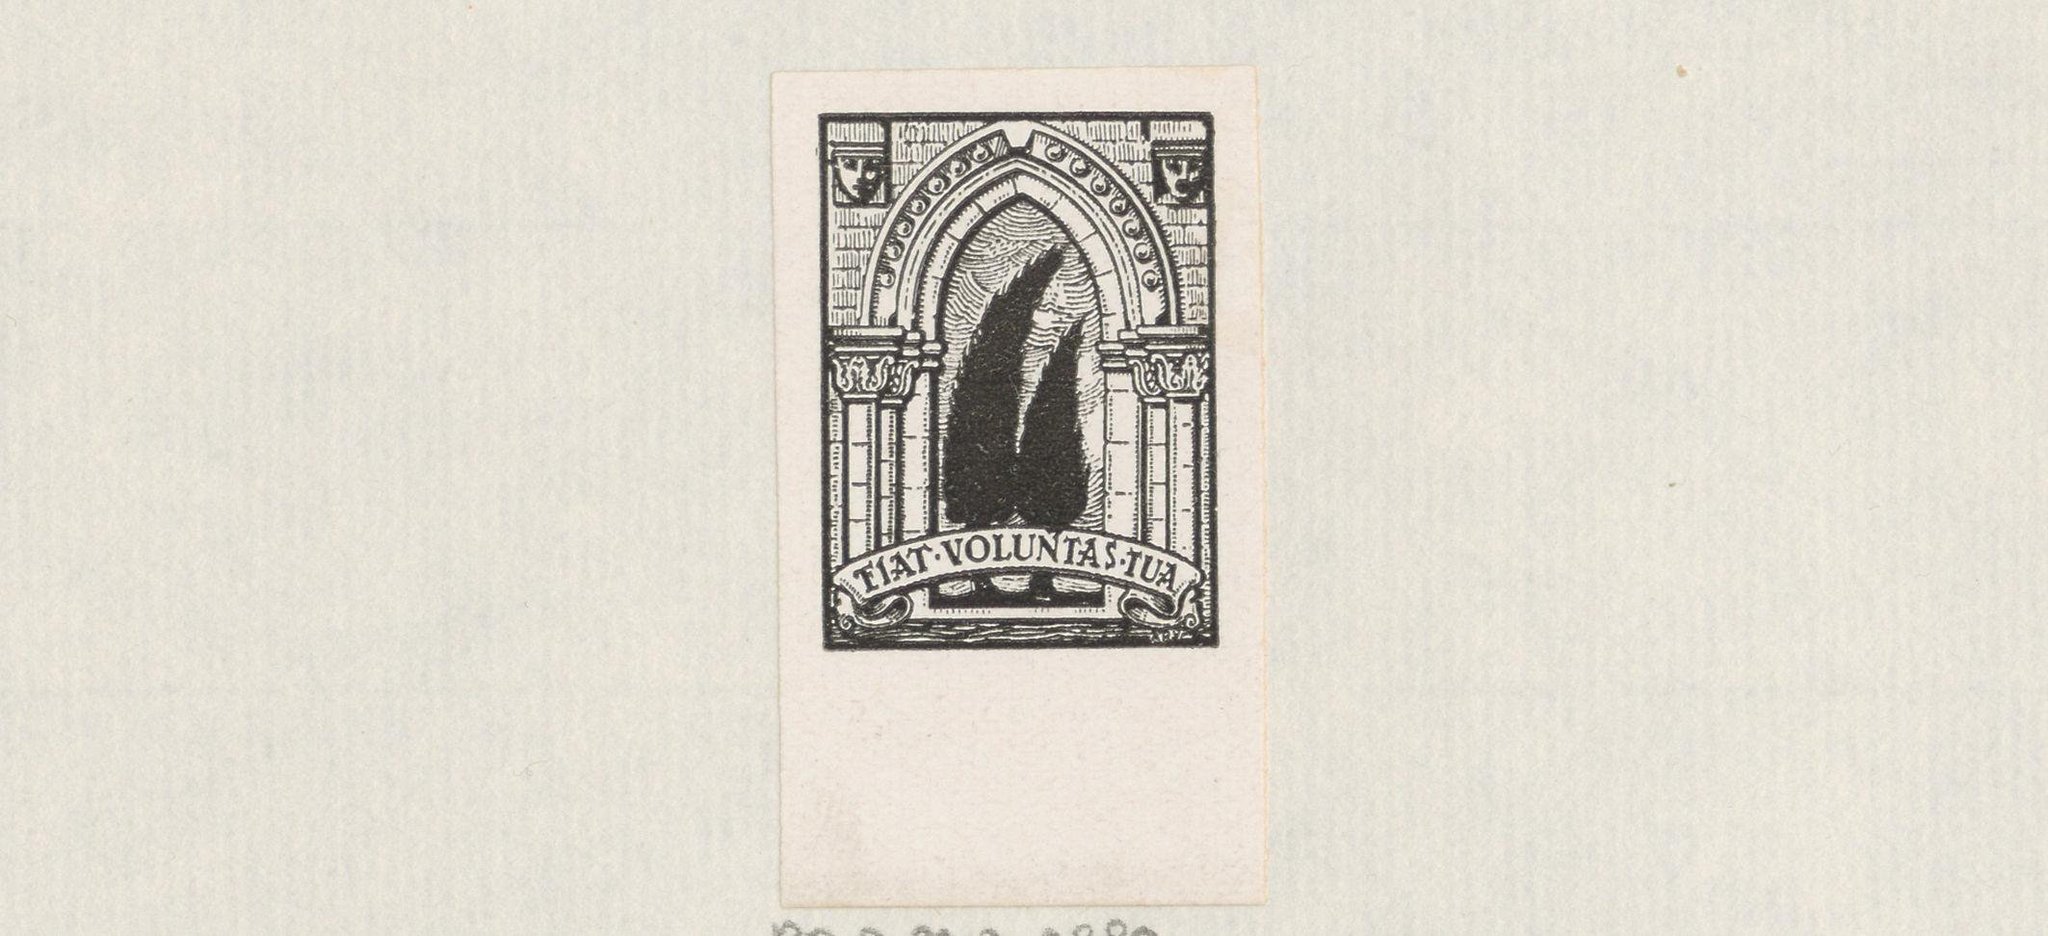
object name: bookplate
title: Ex libris van onbekend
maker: Anonymous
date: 1900-1999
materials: paper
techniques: printing block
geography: portugal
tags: trees, arch, archivolt ~ architecture, capital (~ column, pillar)